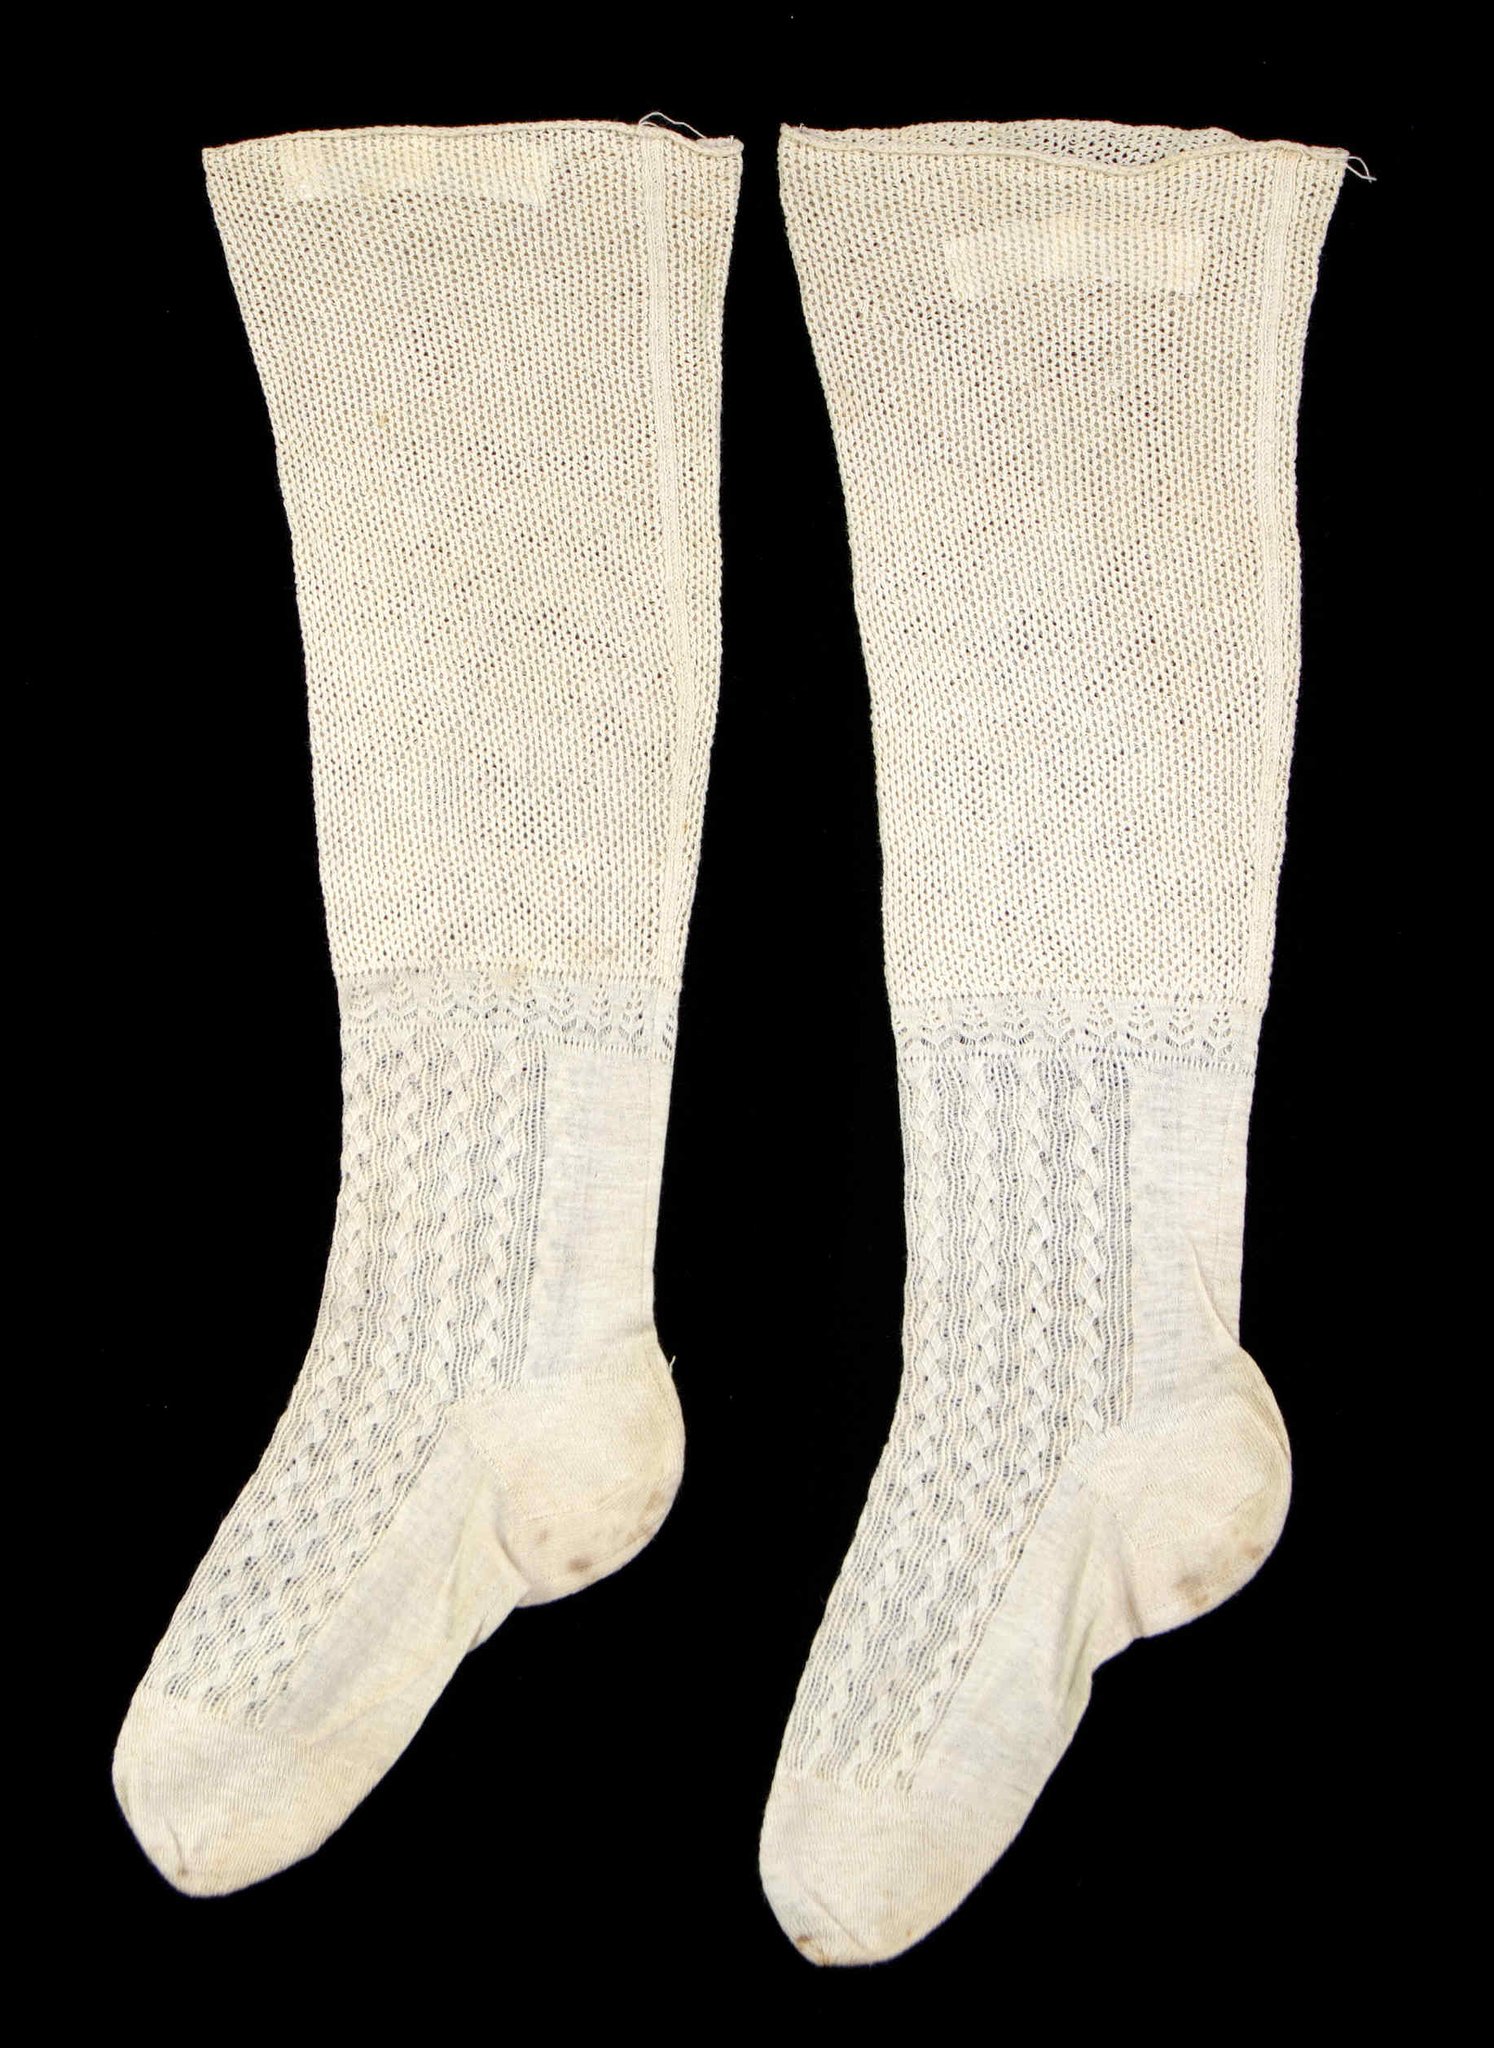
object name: wedding stocking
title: Wedding stockings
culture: american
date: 1863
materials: cotton